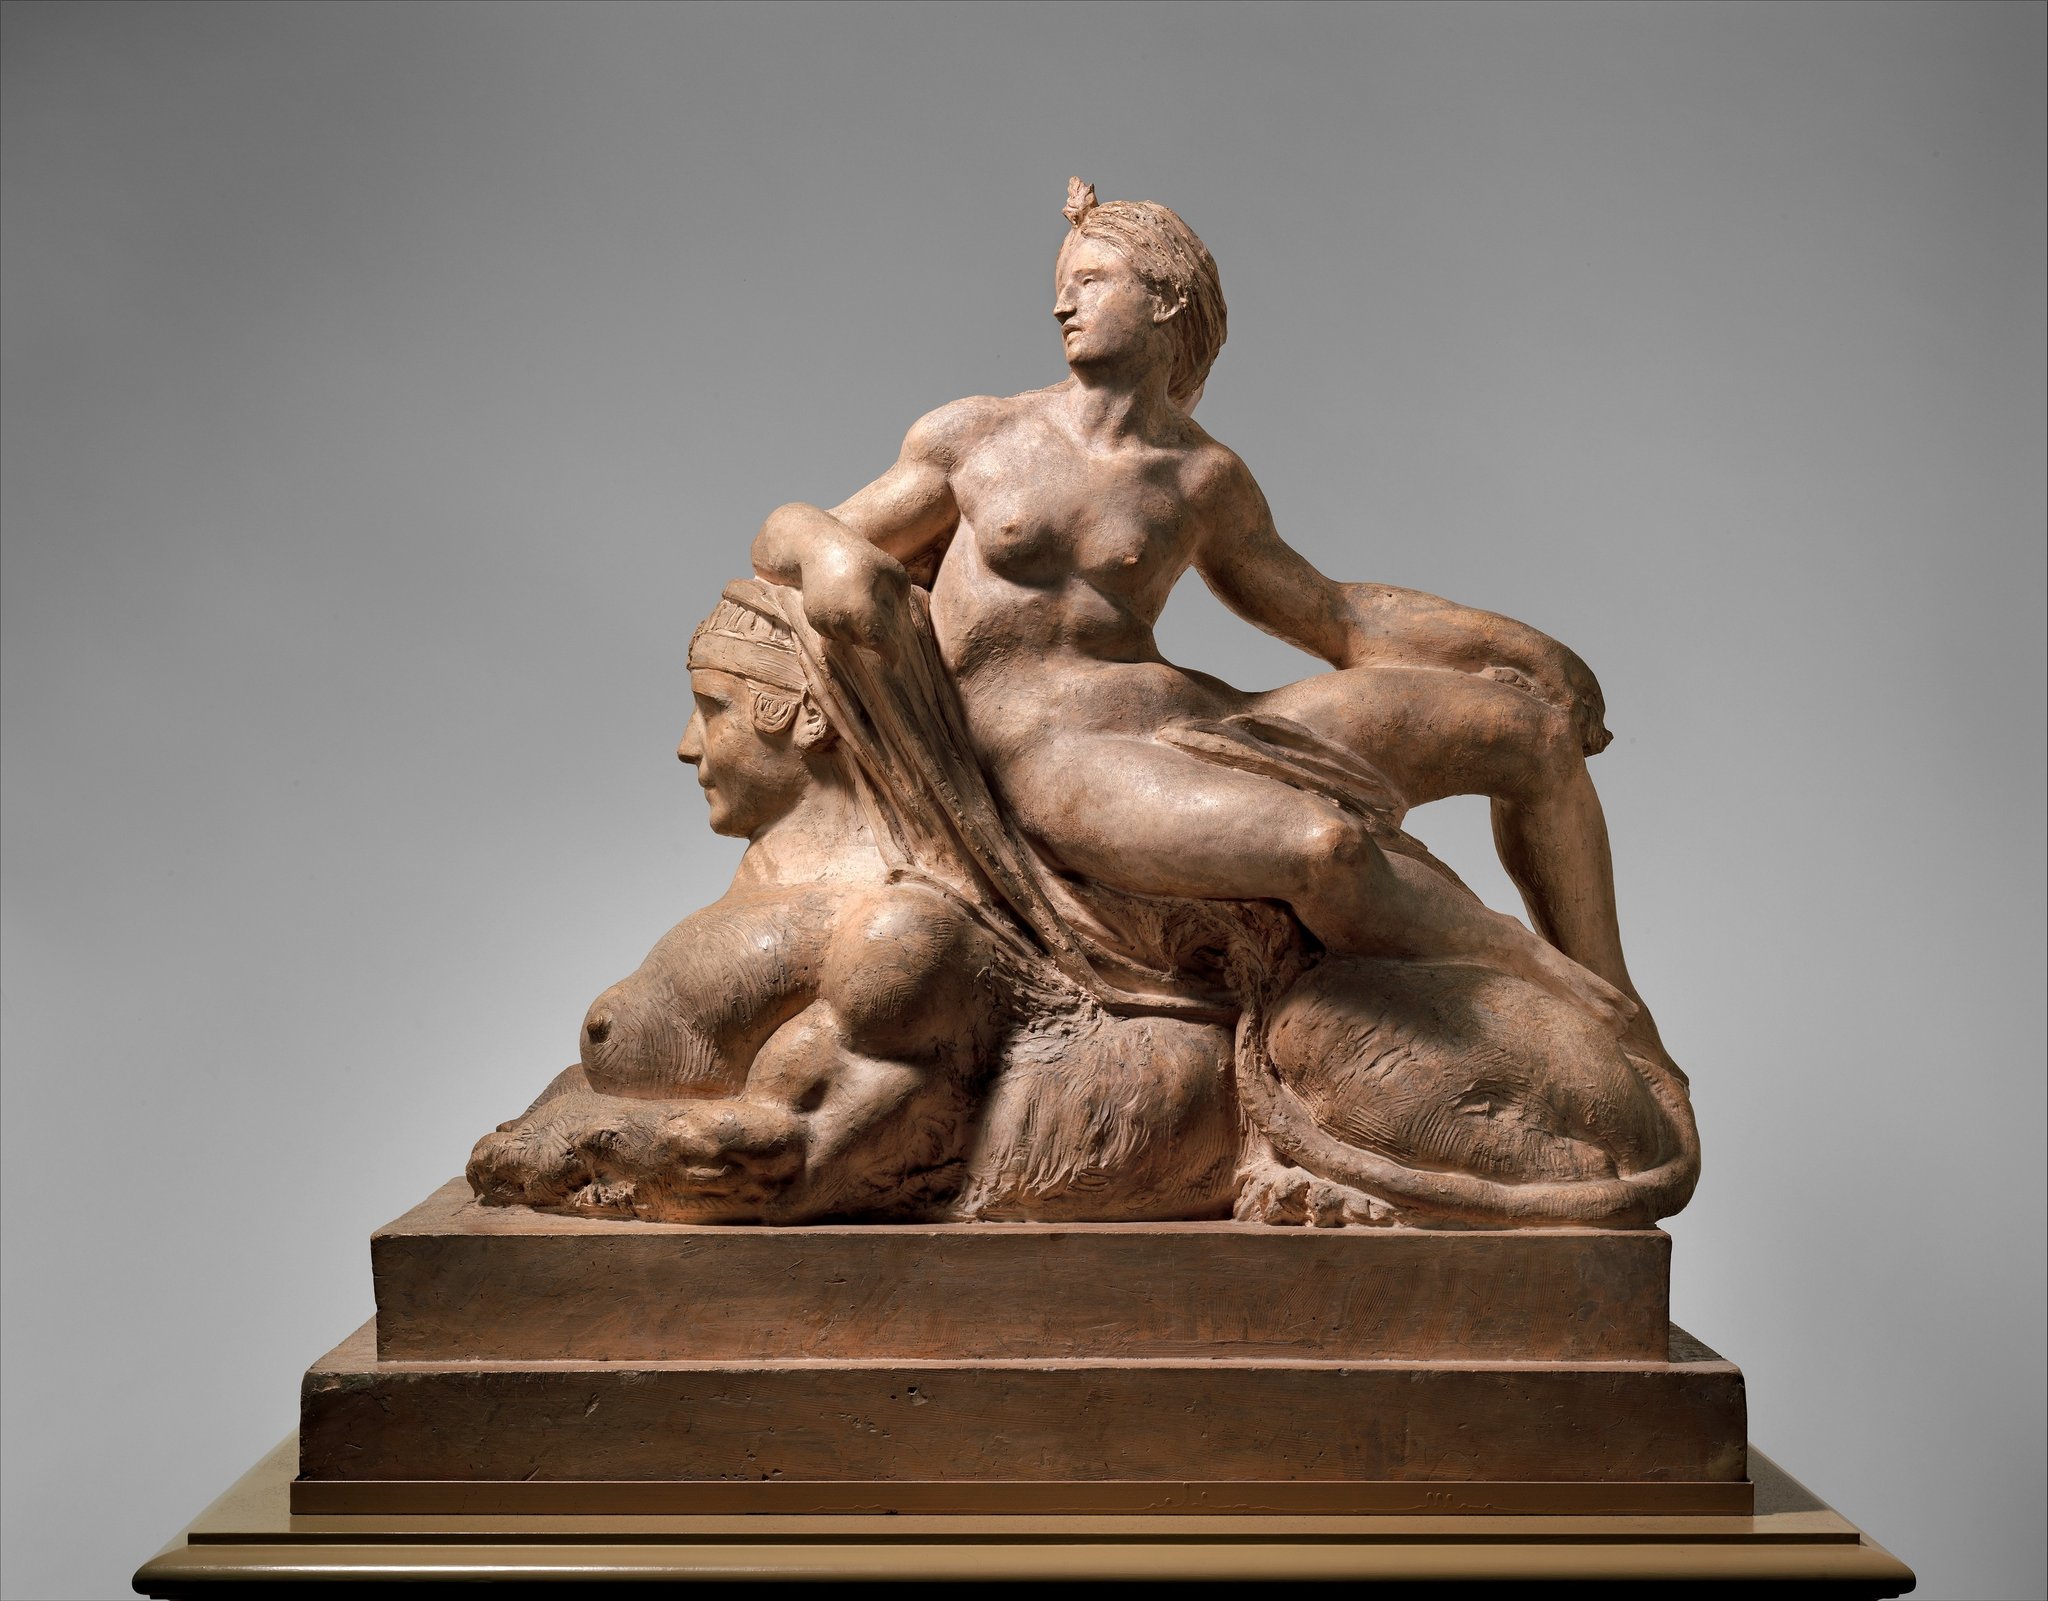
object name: group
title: Venus and the Sphinx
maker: auguste préault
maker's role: artist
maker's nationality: french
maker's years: 1809-1879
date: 1868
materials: plaster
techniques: tinting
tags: sphinx,venus